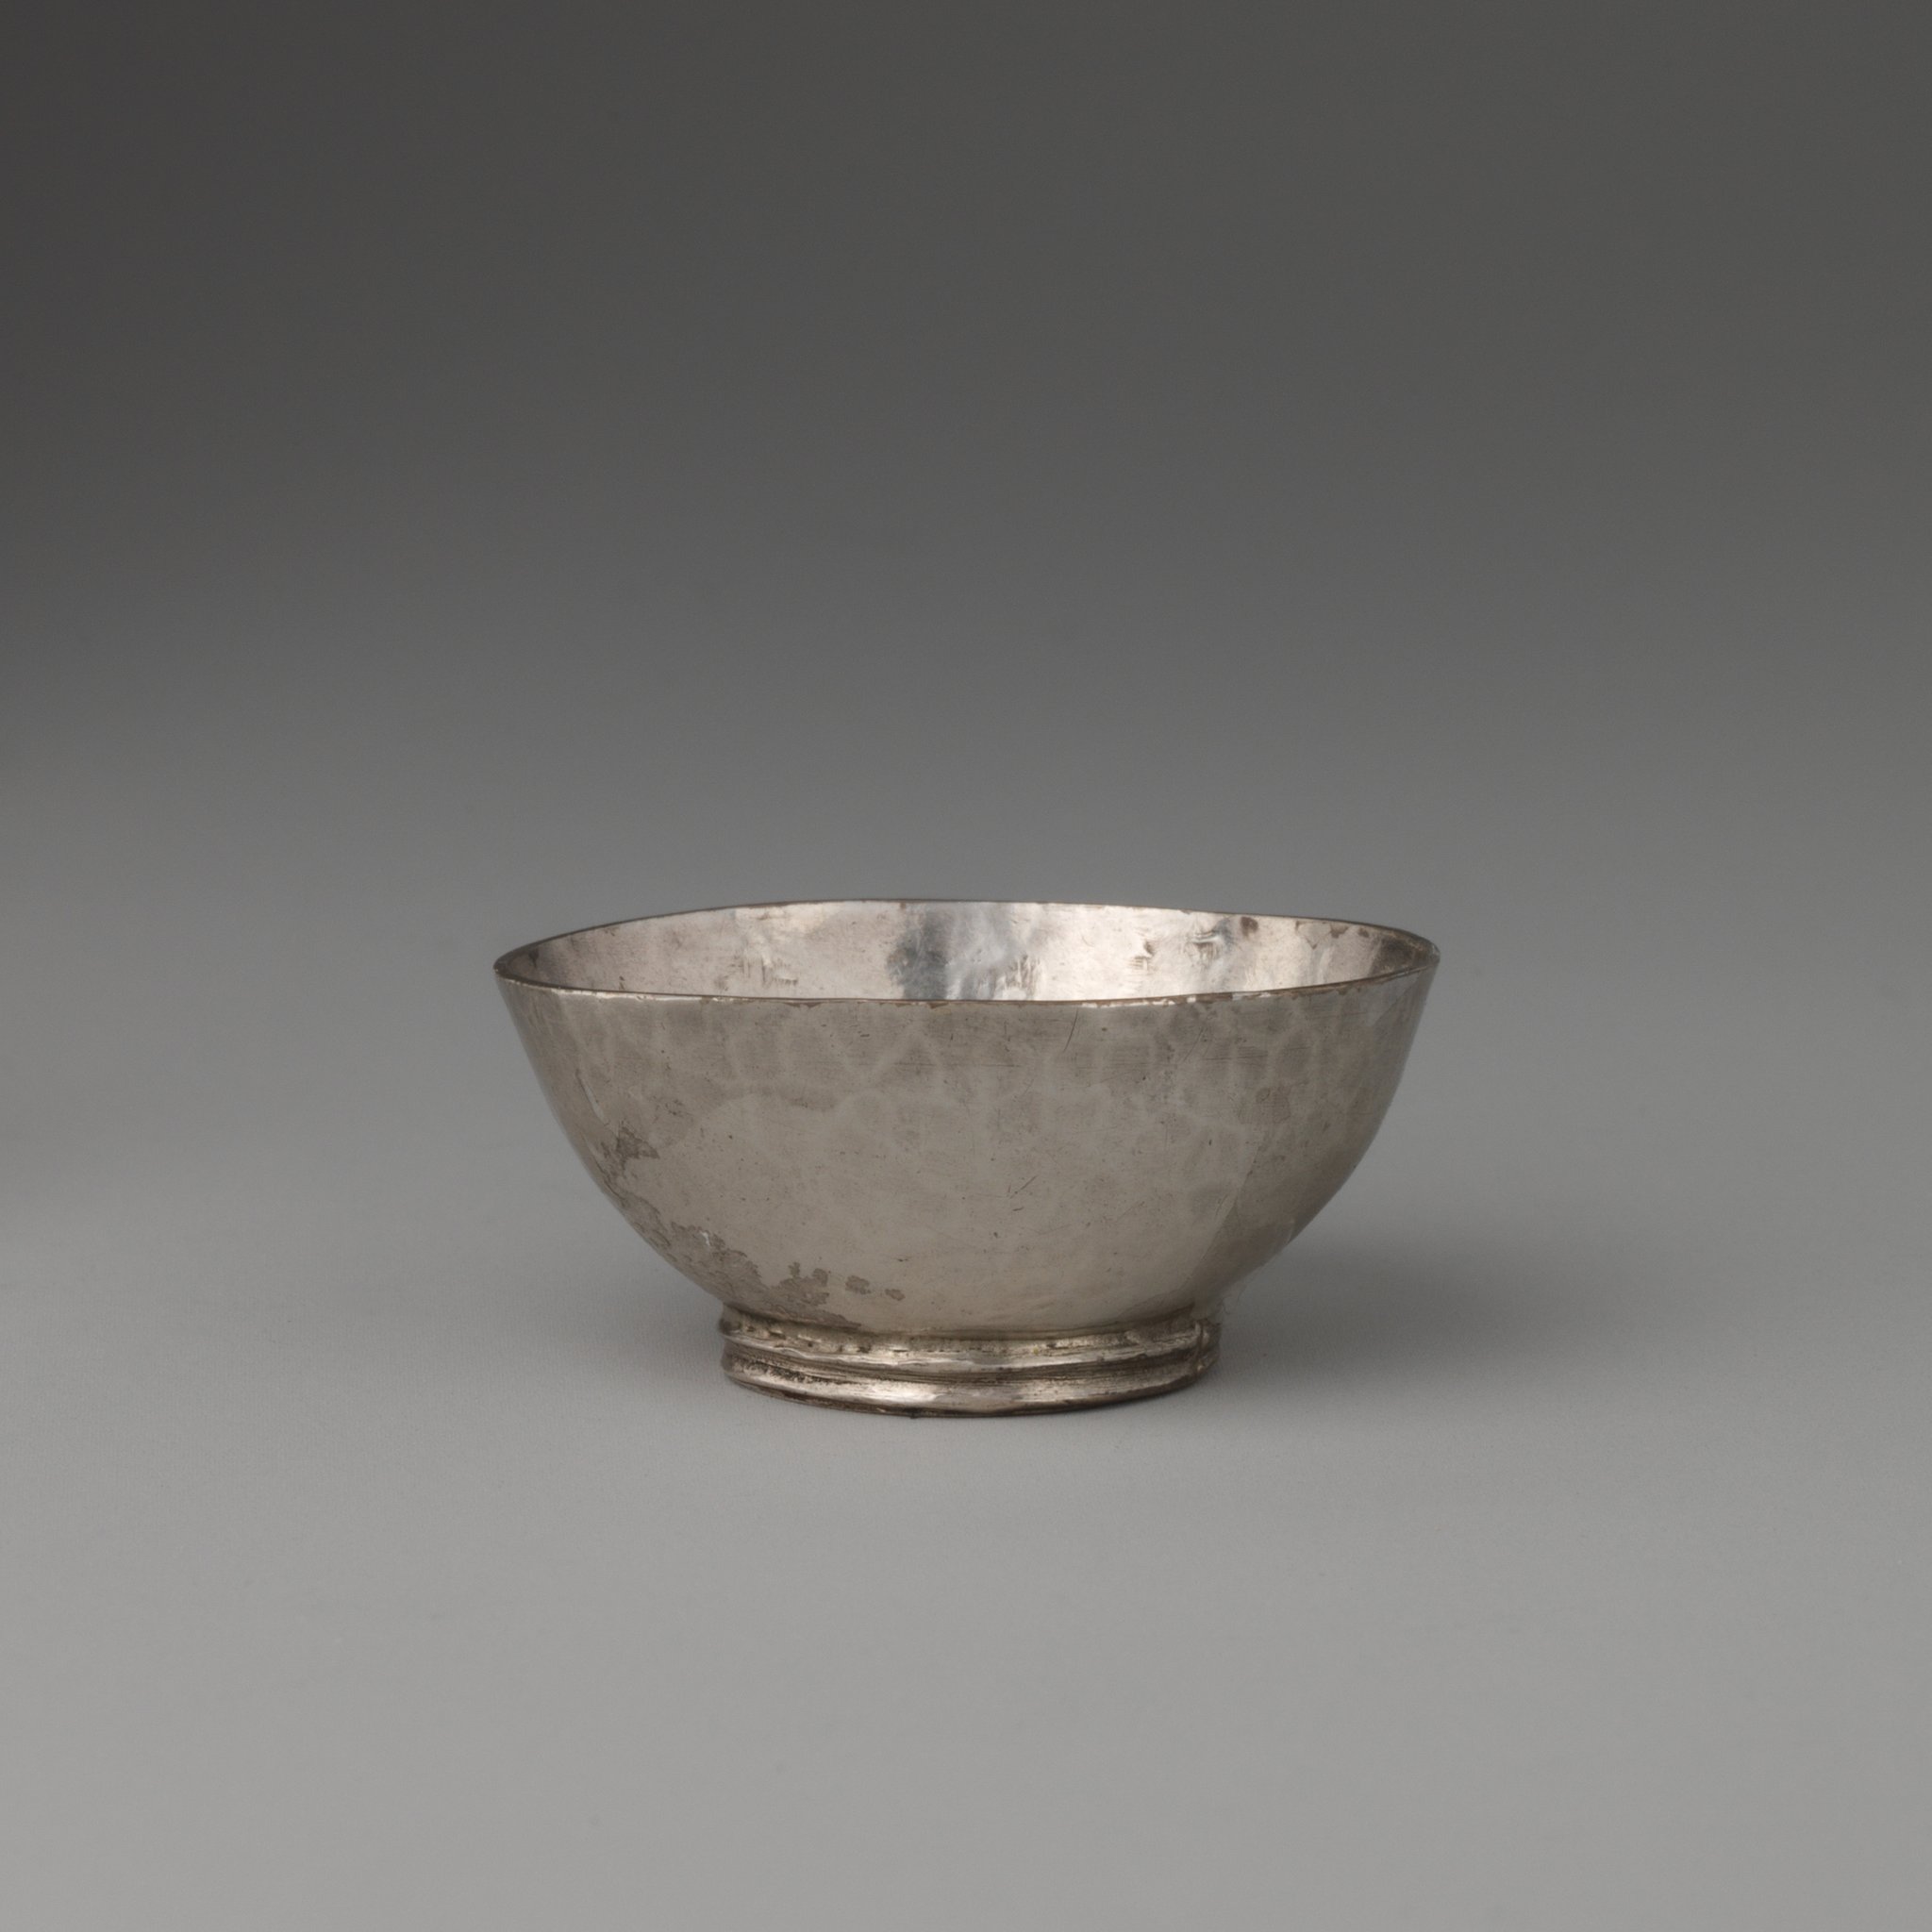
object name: bowl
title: Miniature bowl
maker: george manjoy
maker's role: maker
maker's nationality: british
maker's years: 1685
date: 1690-1691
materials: silver